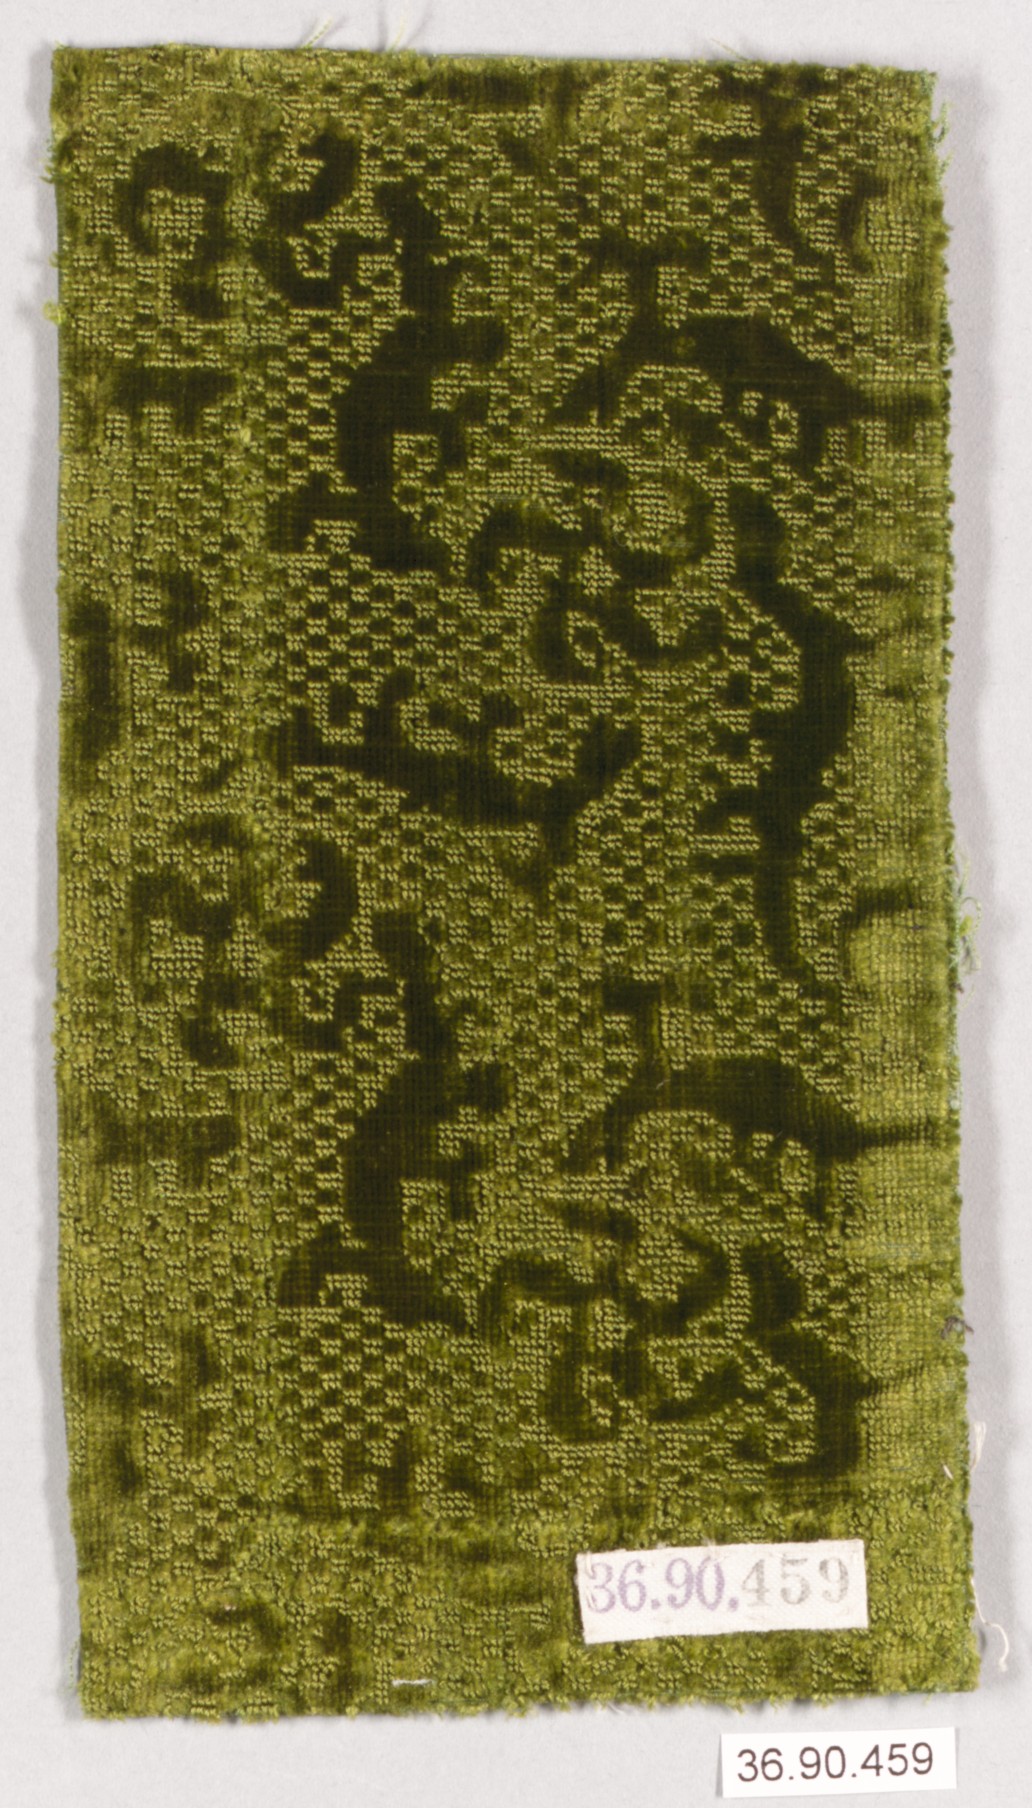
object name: piece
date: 1501-1700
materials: silk